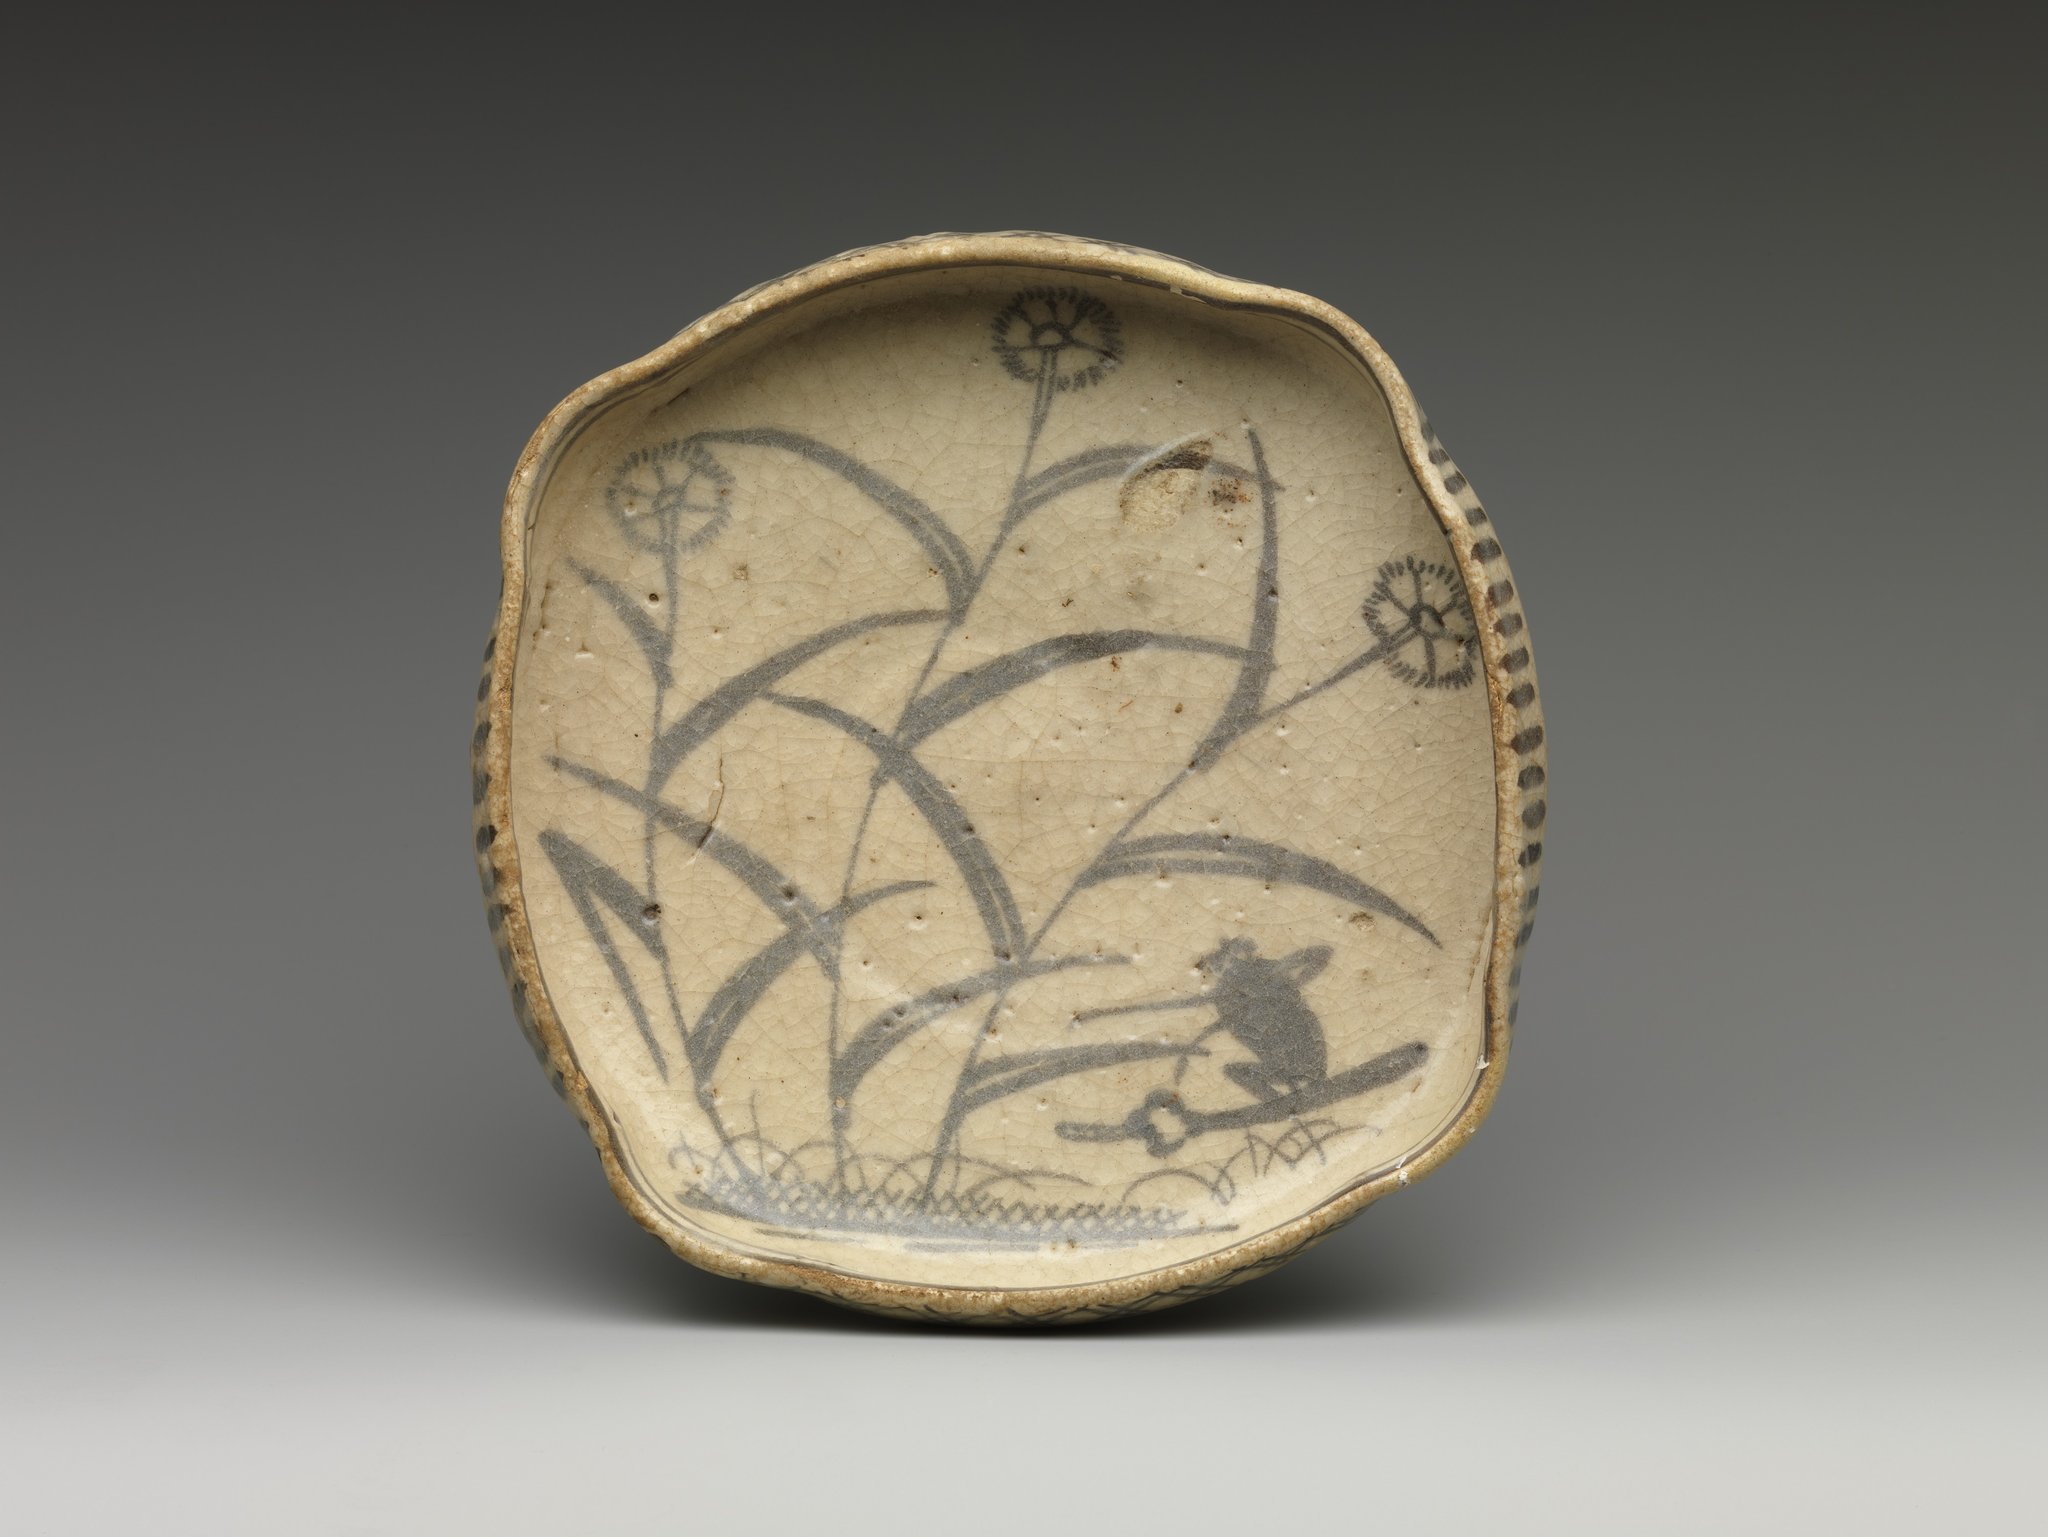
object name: dish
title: Dish with Bird-and-Flower Design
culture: japanese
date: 1601-1633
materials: iron, stoneware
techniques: underglaze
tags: birds,flowers,leaves